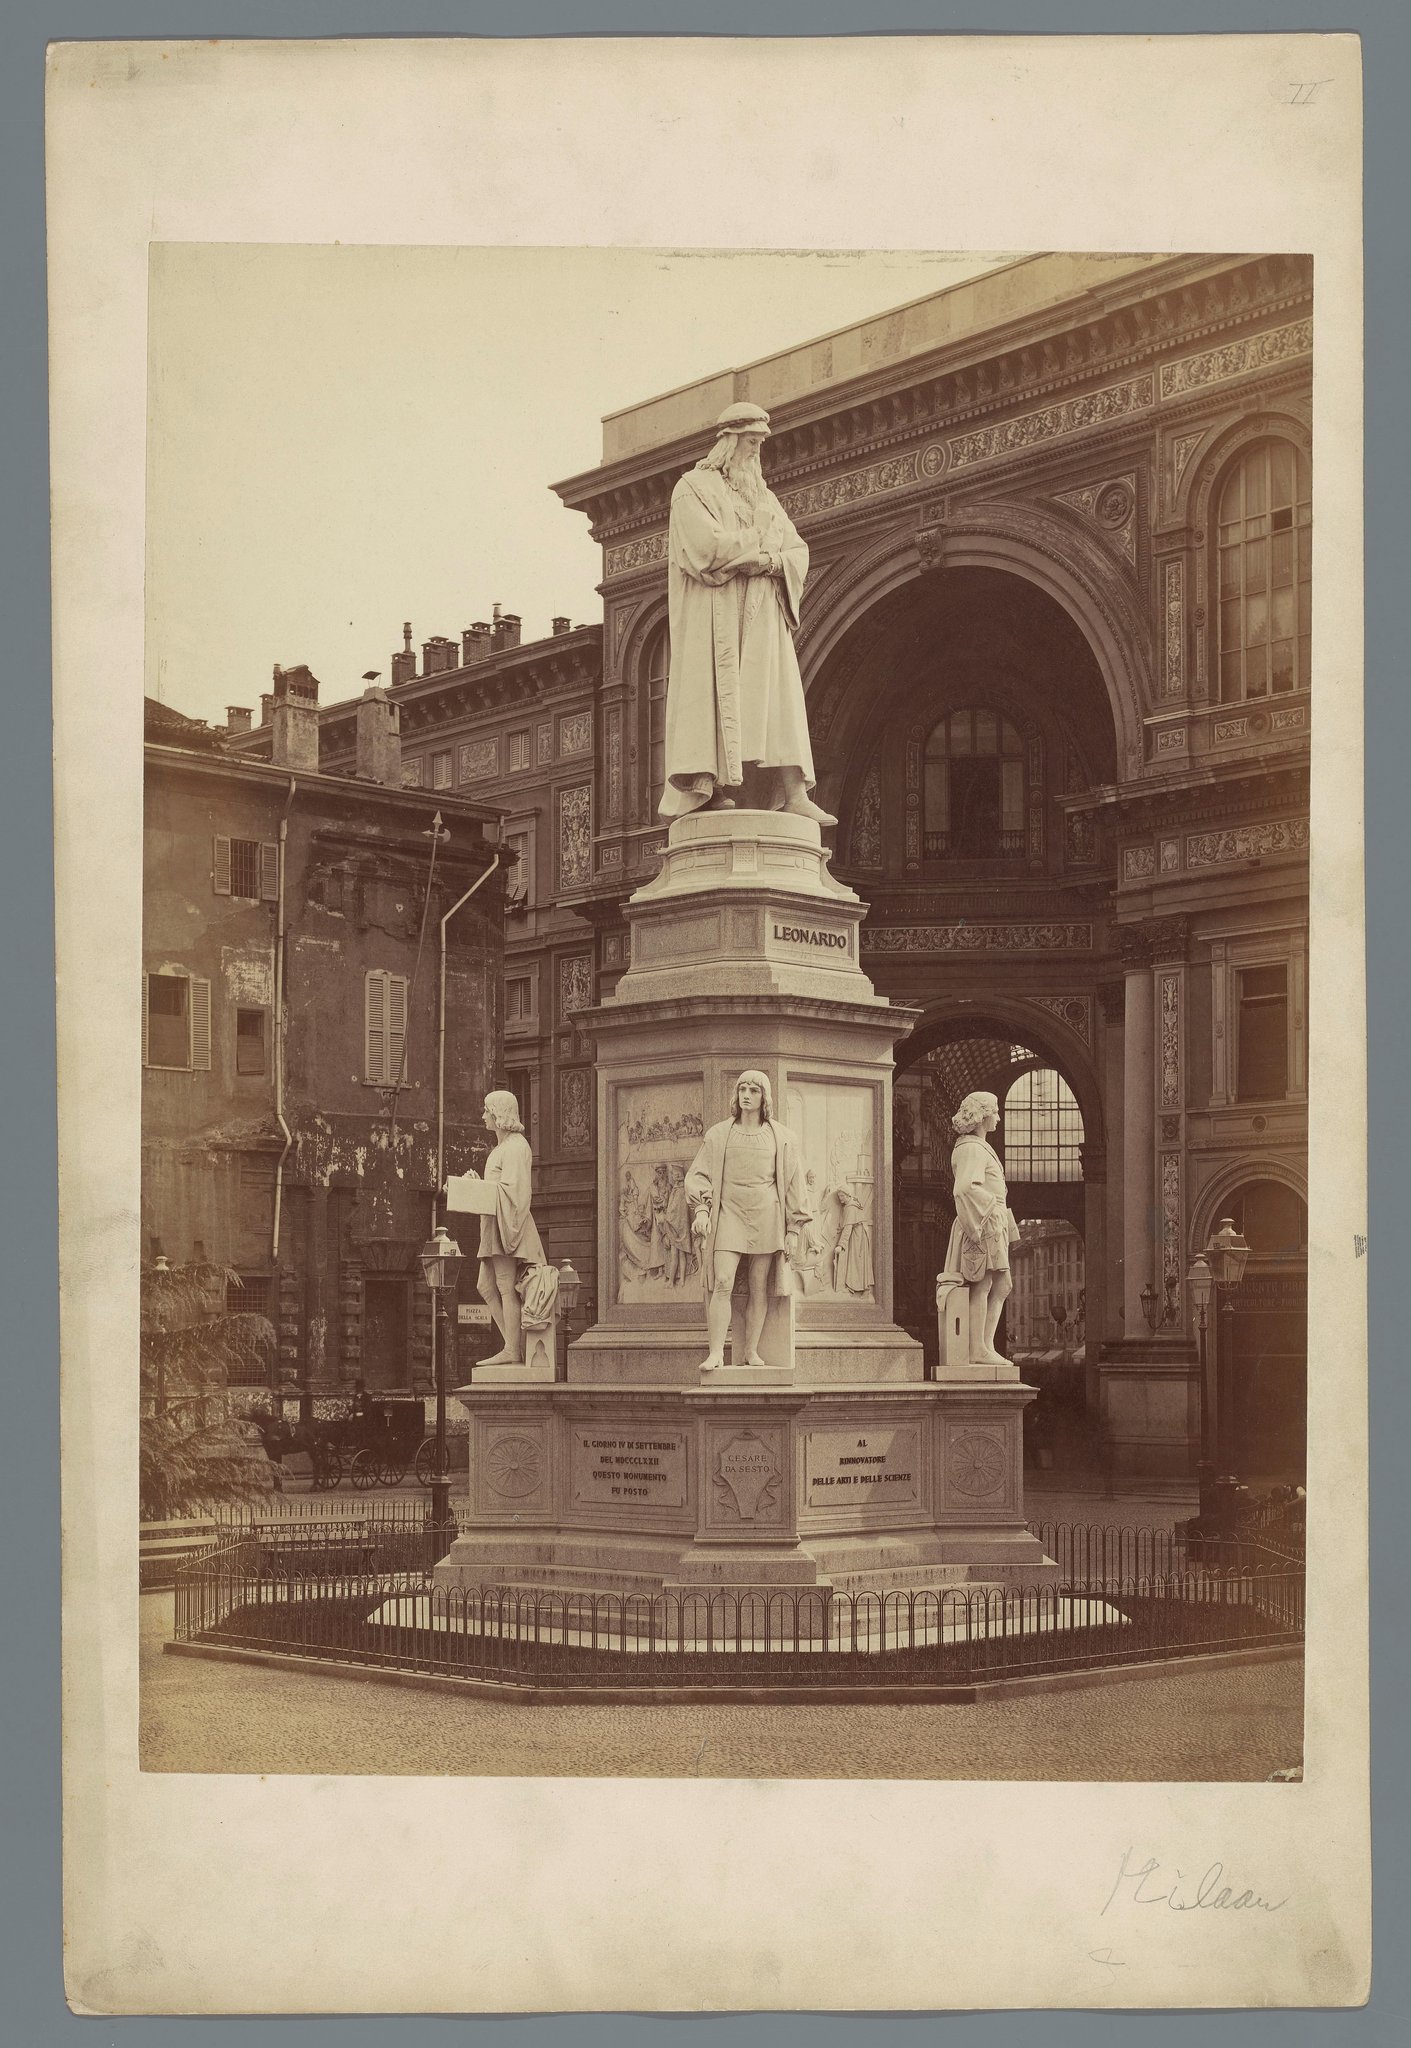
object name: stereograph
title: Gezicht op de Pont Louis-Philippe in Parijs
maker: Anonymous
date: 1855-1860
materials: cardboard, photographic support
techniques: salted paper print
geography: paris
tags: bridge in city across river, canal, etc.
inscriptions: inscription: ‘Pont Louis Philippe Paris’